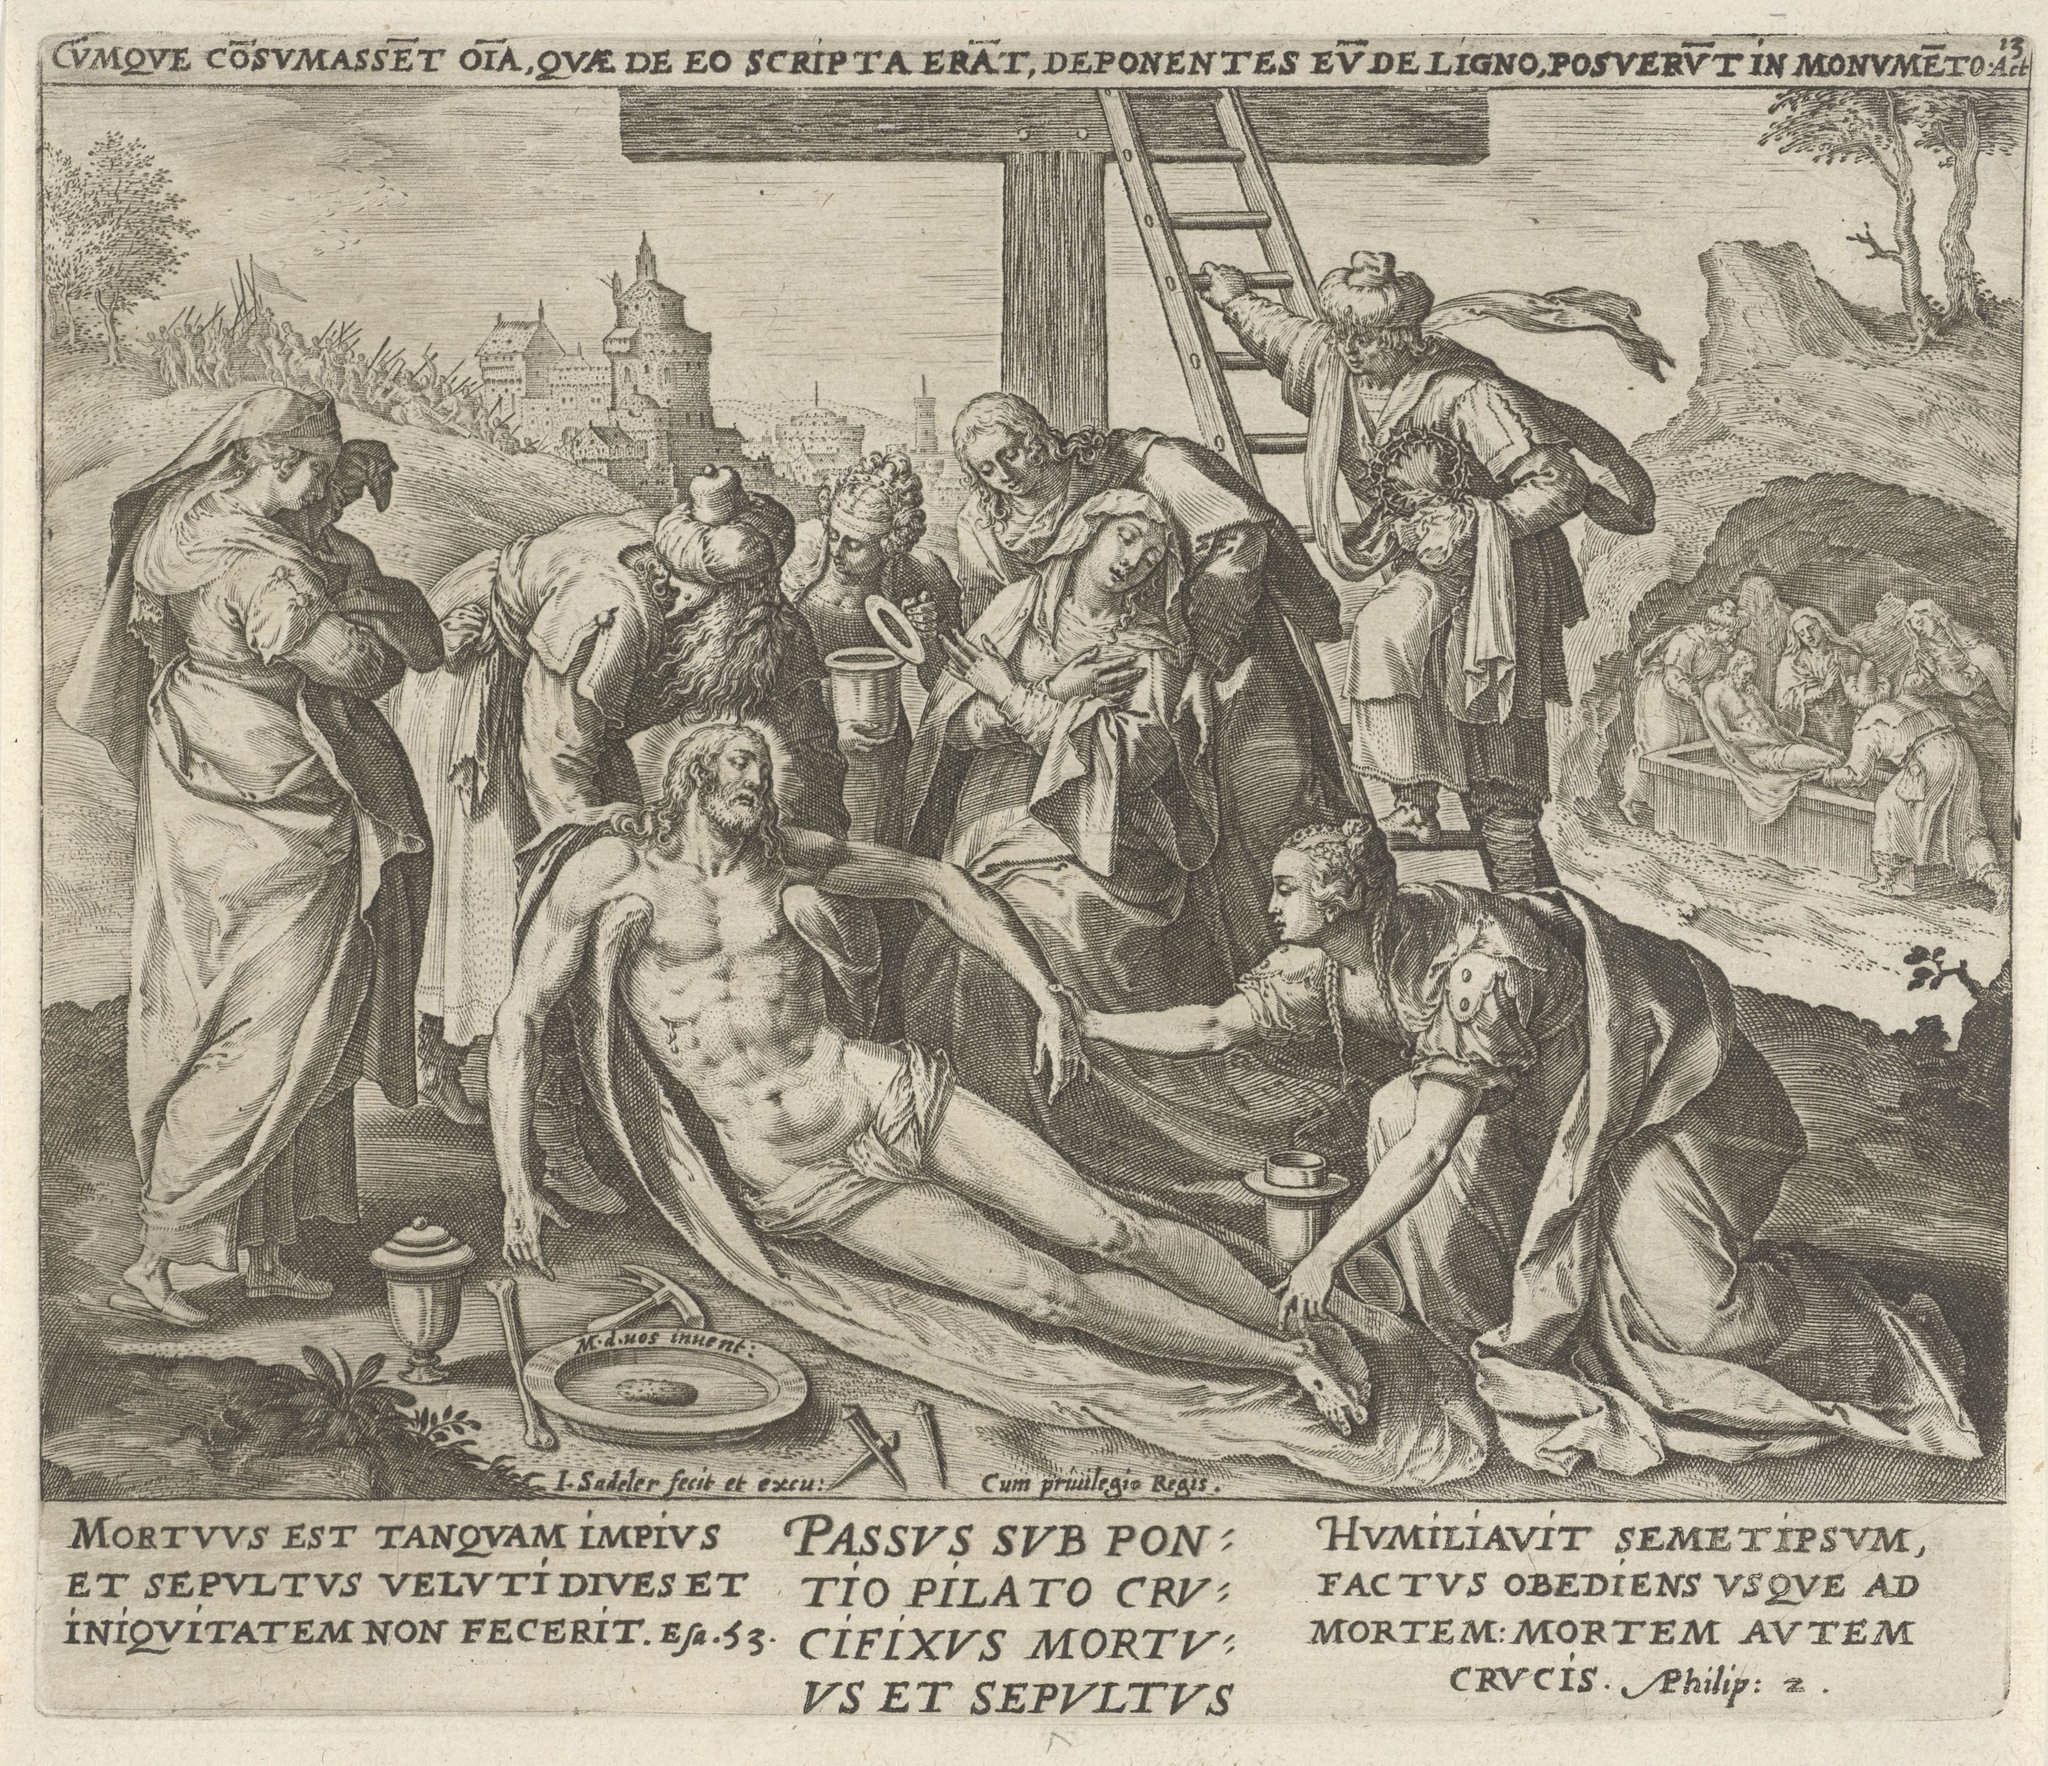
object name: print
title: Passvs svb Pontio Pilato crucifixvs mortvvs et sepvltvs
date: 1579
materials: paper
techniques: engraving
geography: cologne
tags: christ's entombment (possibly by angels), 'passus sub pontio pilato, crucifixus, mortuus et sepultus est' ~ articles of faith, lamentation over the dead christ by his relatives and friends (christ usually without crown of thorns)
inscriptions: collector's mark: Lugt 240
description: Het vierde geloofsartikel: het geloof in de dood van Christus aan het kruis. De prent toont de maagd Maria en anderen die het dode lichaam van Christus bewenen, dat van het kruis is afgehaald. Op de achtergrond rechts wordt Christus in een tombe gelegd. De prent heeft een Latijns opschrift met een Bijbelcitaat dat refereert naar het afgebeelde Bijbelverhaal en een Latijns onderschrift over de apostolische geloofsbelijdenis. De vierde prent in een twaalfdelige serie over het credo.